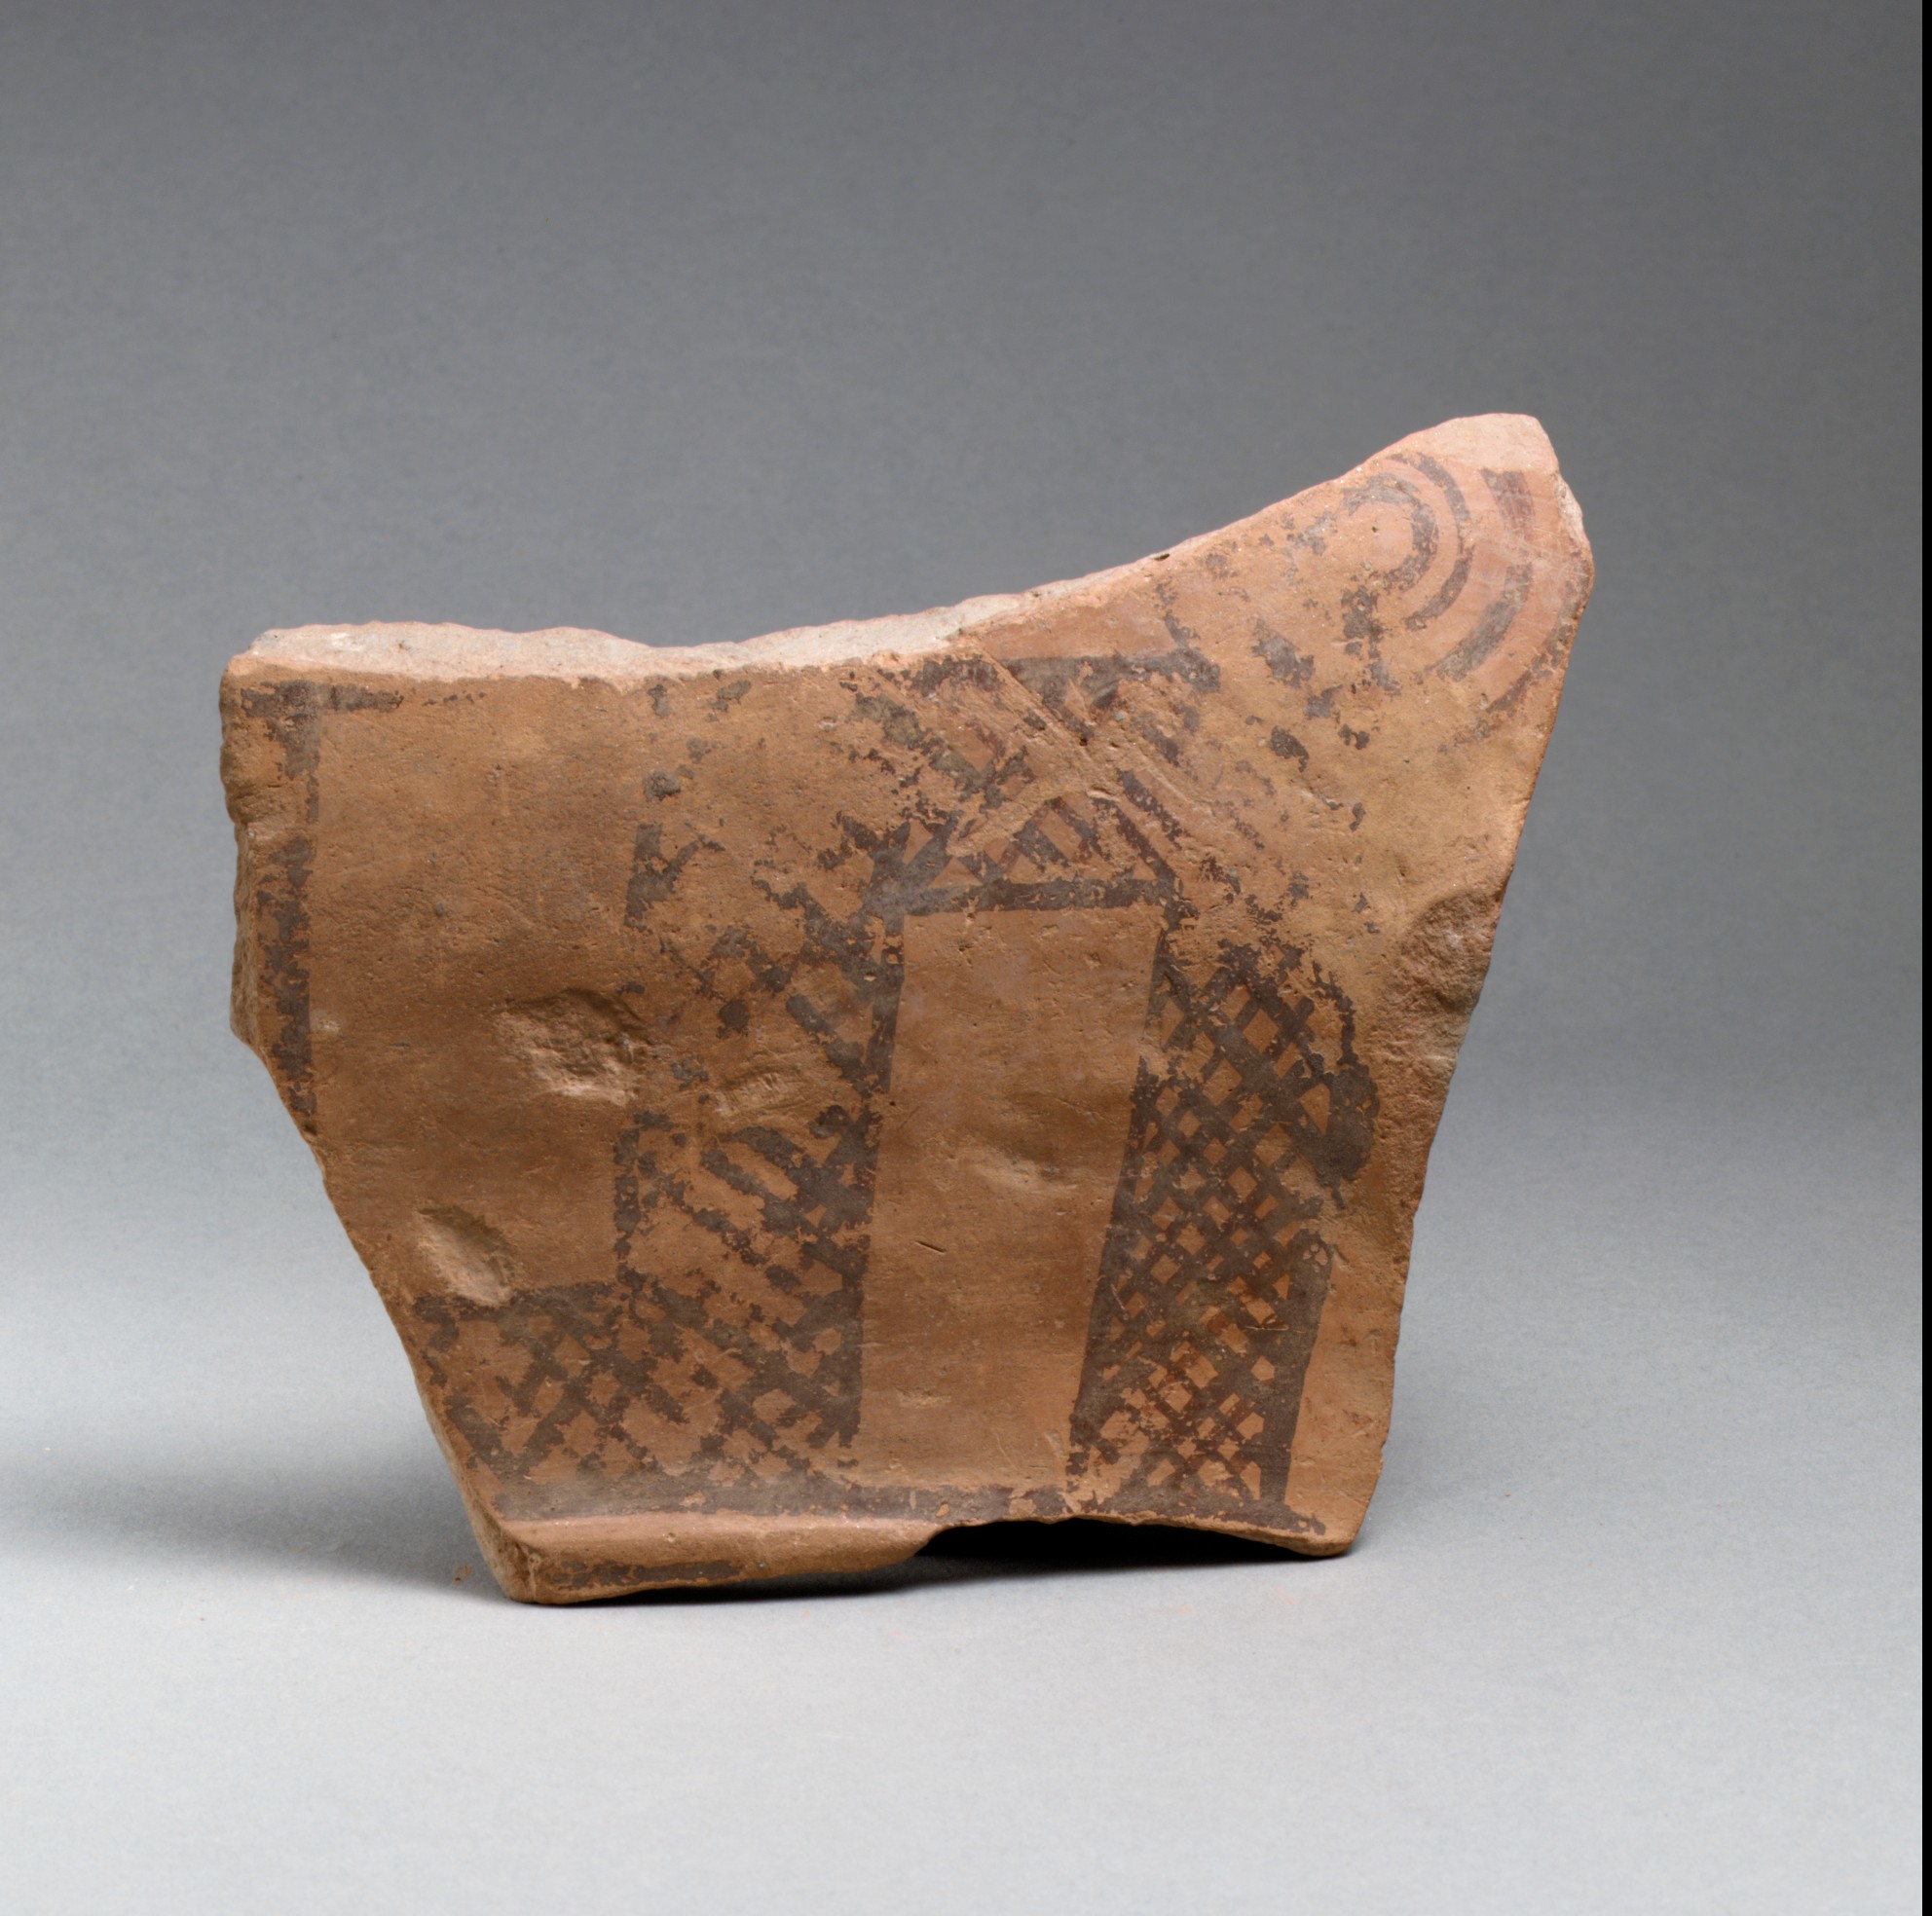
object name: vase fragment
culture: greek or lydian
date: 1050-700 BCE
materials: terracotta